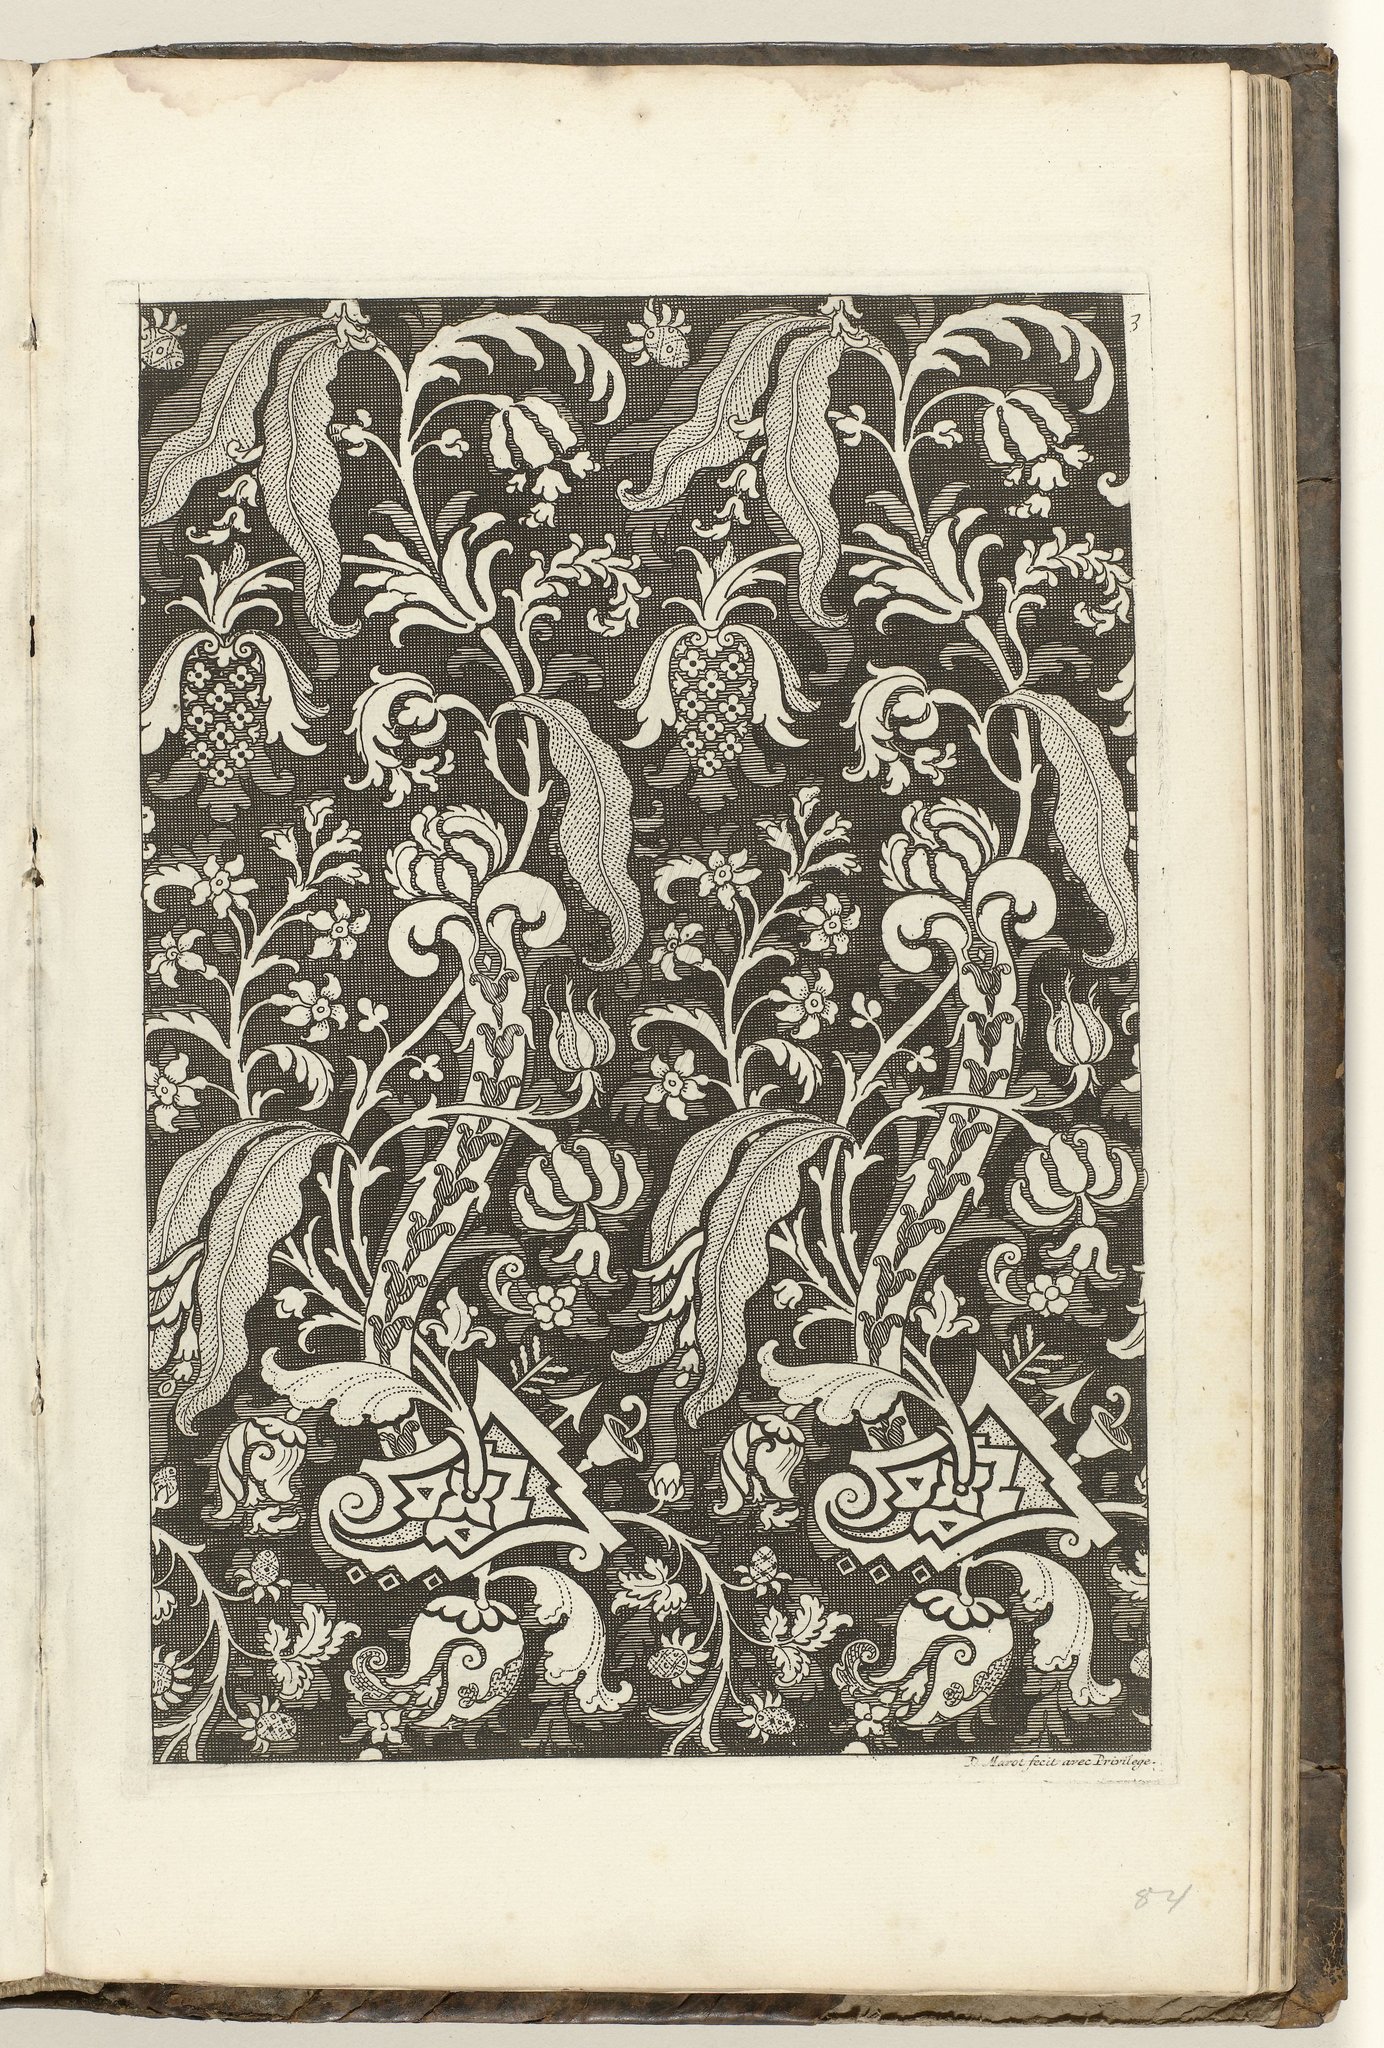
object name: ornament print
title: Patrons d'etoffes et de velours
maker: daniël marot (i)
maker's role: draughtsman, print maker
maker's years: 1661-1752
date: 1703-1712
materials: paper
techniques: etching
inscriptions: signature: ‘D. Marot fecit avec privilege’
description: Repetitive pattern in white and greys on a black ground; stylised flowers, fruit and naturalistically depicted foliate scrolls....and a foliate scroll. Prent uit 'De werken van Daniel Marot...', 1705.